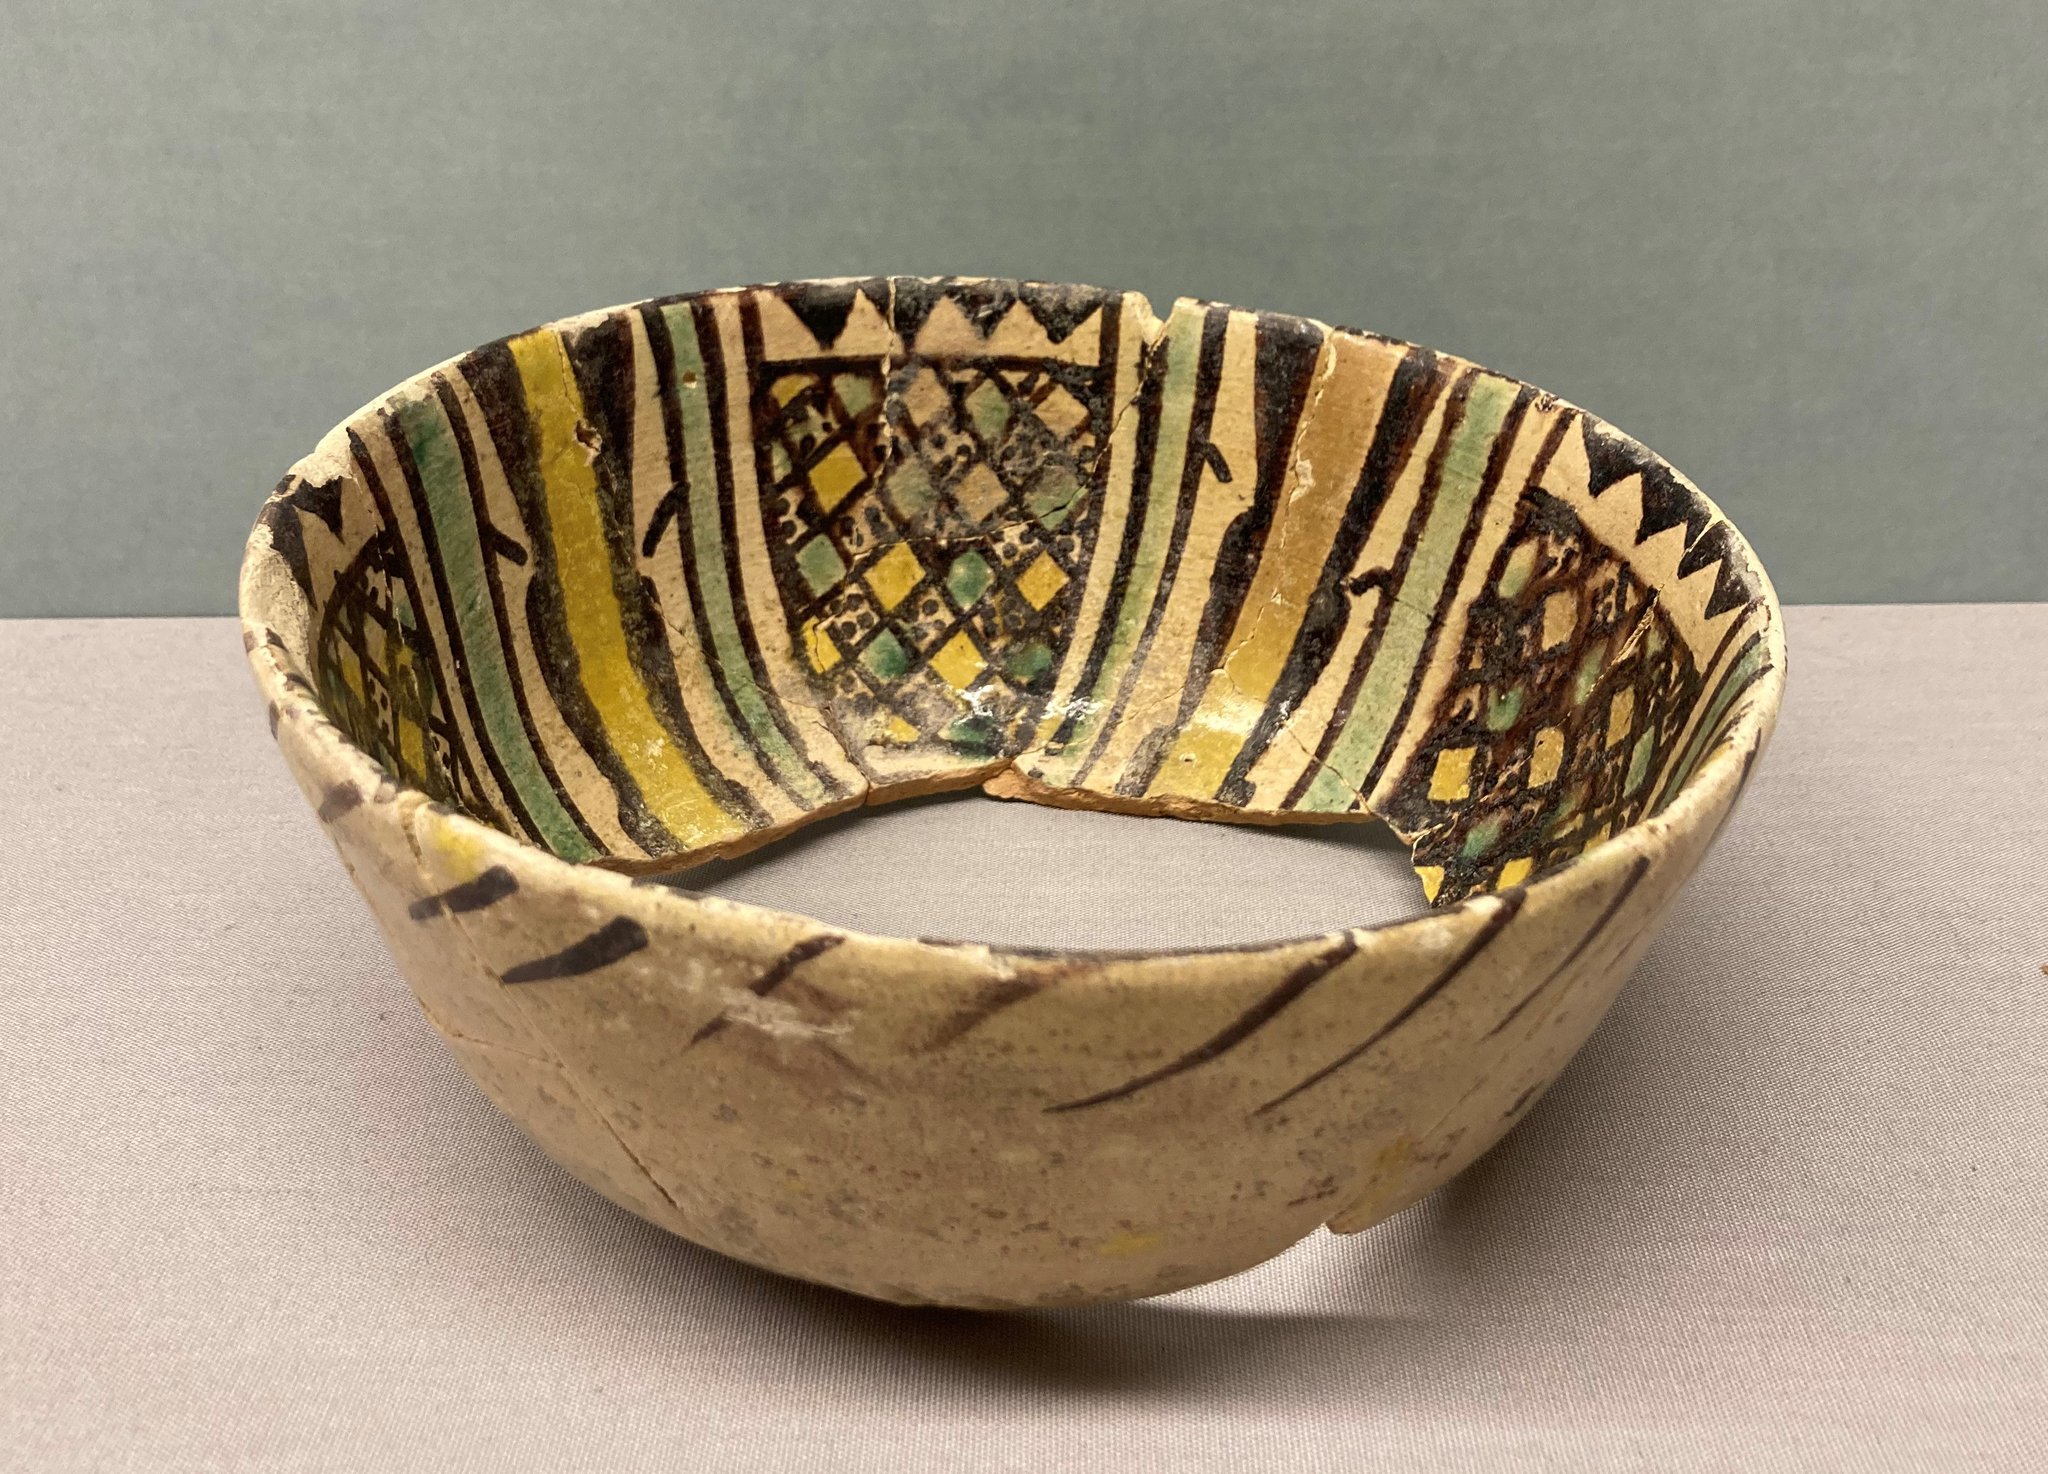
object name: bowl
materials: earthenware, glaze, pigment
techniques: painting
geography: iran